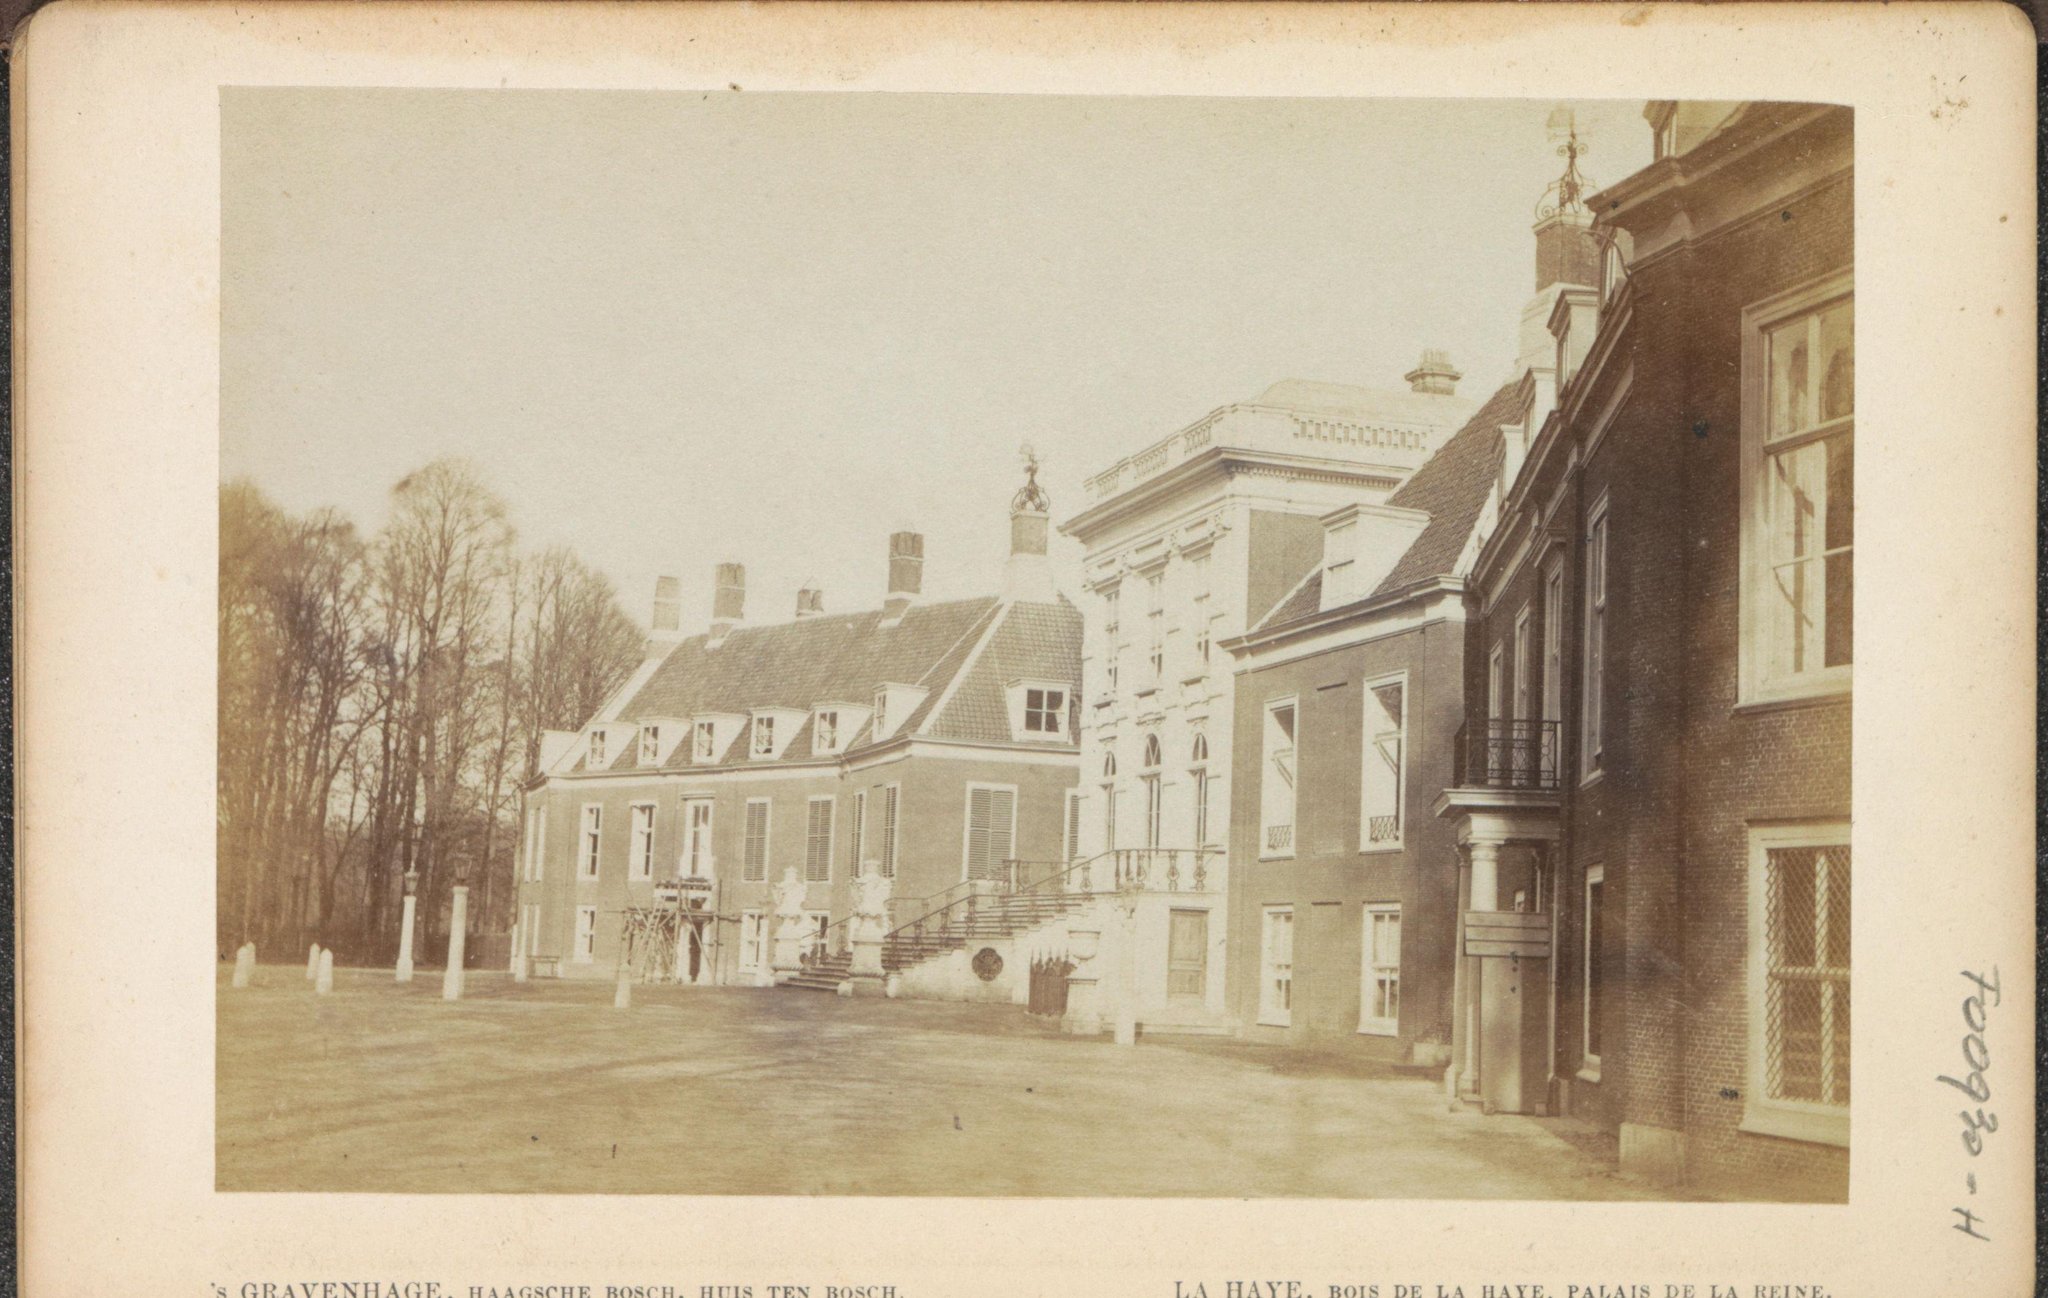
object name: cabinet photograph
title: 's Gravenhage, Haagsche Bosch, Huis Ten Bosch. La Haye, Bois de la Haye, Palais de la Reine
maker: andries jager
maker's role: publisher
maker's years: 1825-1905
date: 1865-1870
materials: cardboard, photographic support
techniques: albumen print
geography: the hague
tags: palace, terrace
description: Onderdeel van Leporelloalbum met foto's van Den Haag.